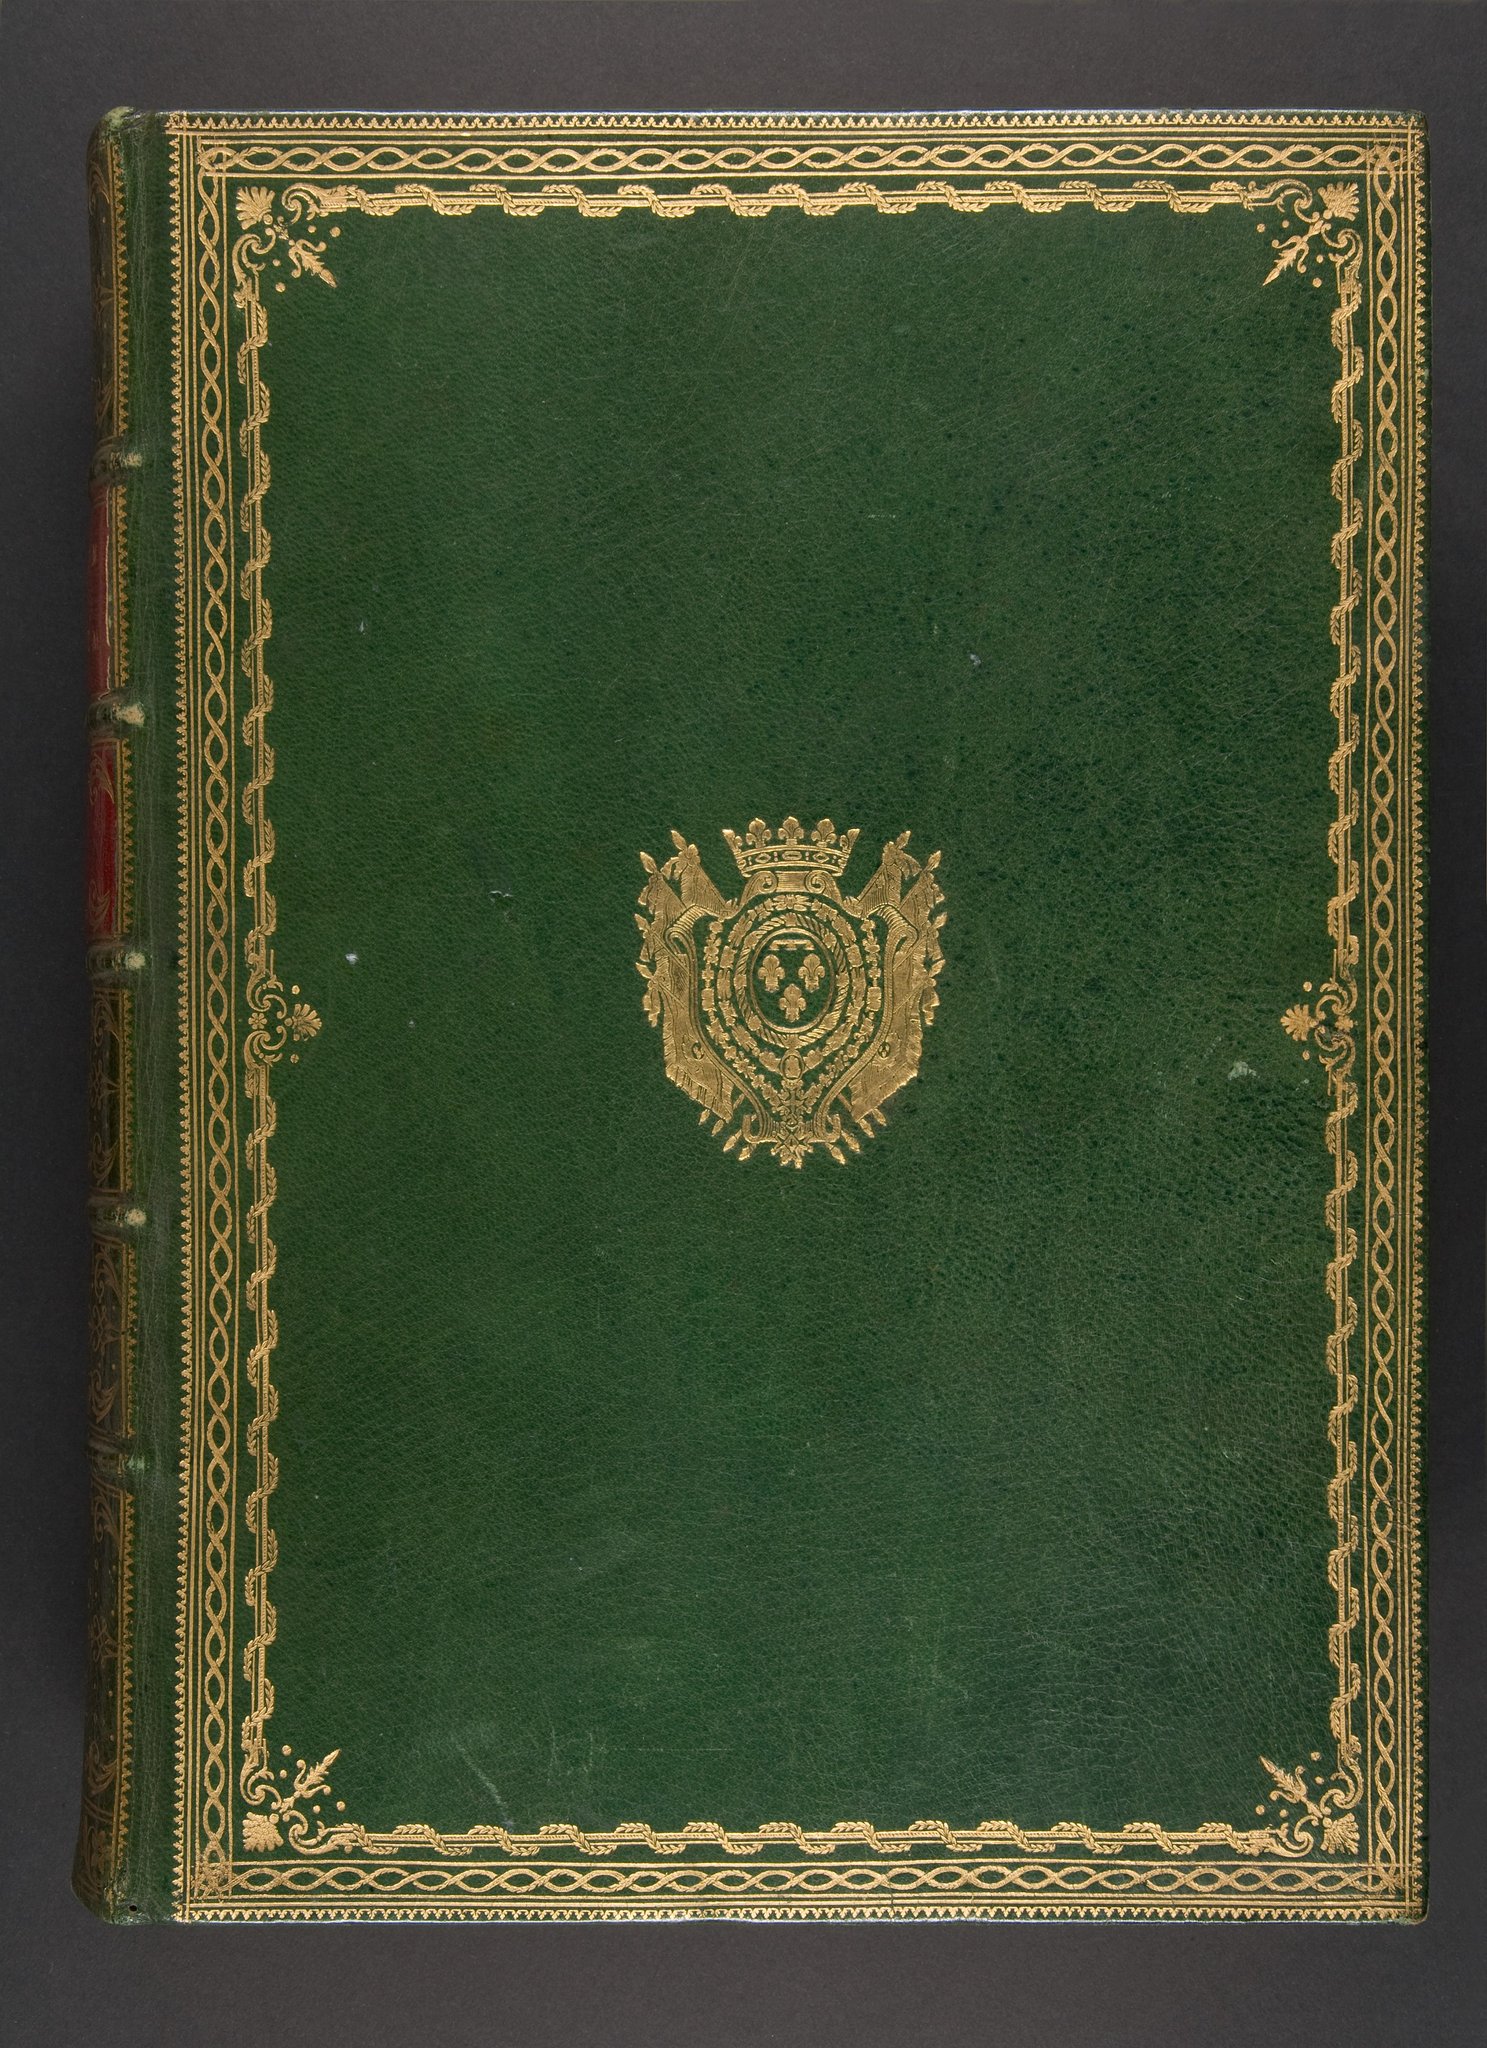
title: Bibliorum Sacrorum Vulgatae versionis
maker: françois ambroise didot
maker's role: printer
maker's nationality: french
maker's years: 1730-1804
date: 1785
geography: france